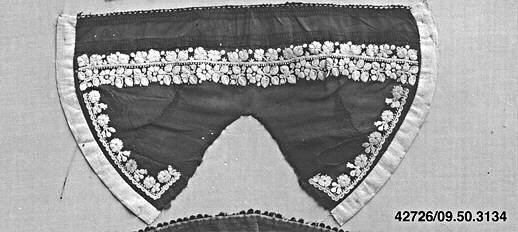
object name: fragment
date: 1801-1833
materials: silk